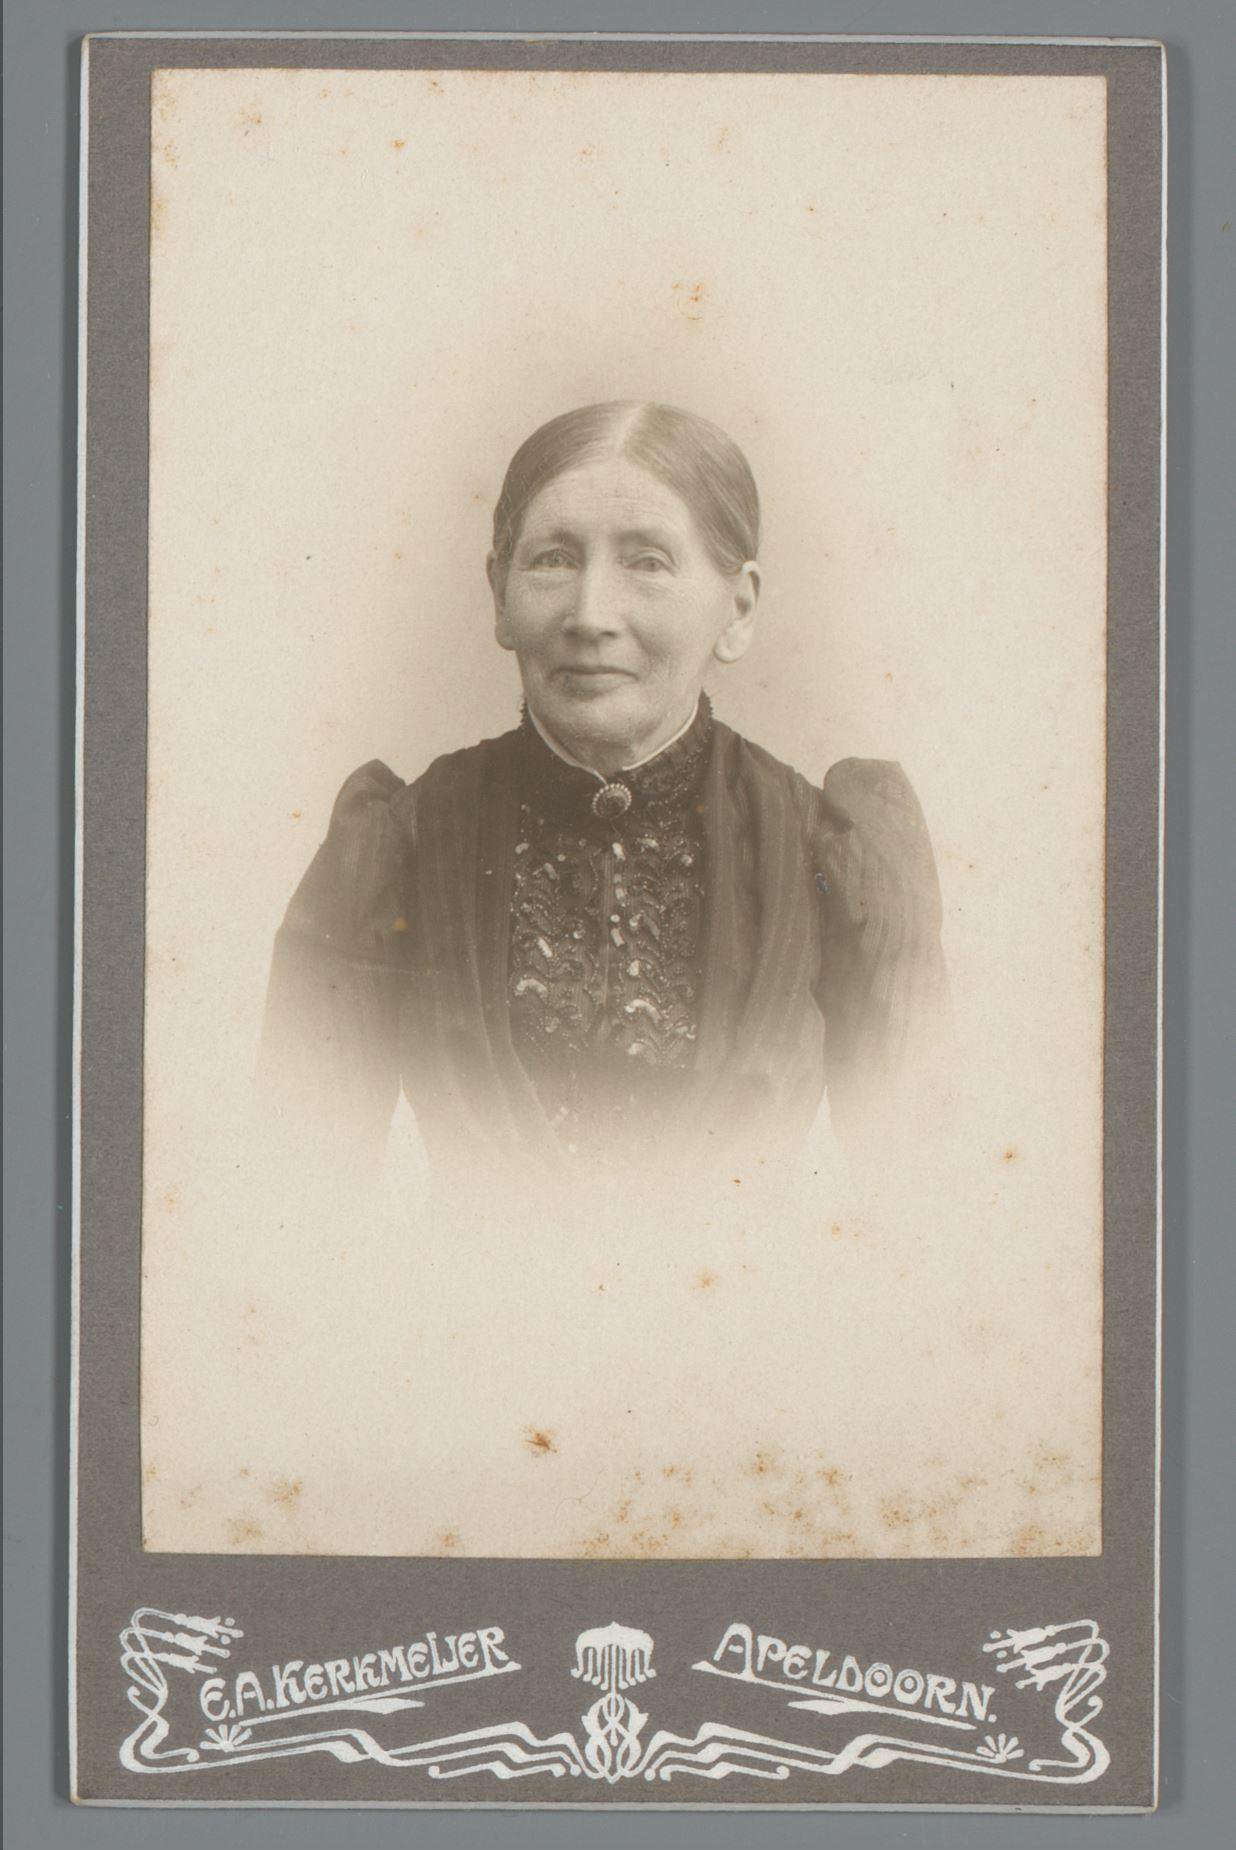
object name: carte de visite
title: Portret van Cornelia Hendrika Nije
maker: evert antonius kerkmeijer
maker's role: fotograaf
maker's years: 1864-1932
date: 1885-1930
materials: cardboard, photographic support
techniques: collodion silver print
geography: apeldoorn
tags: historical persons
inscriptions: name: ‘C.H. Nije’